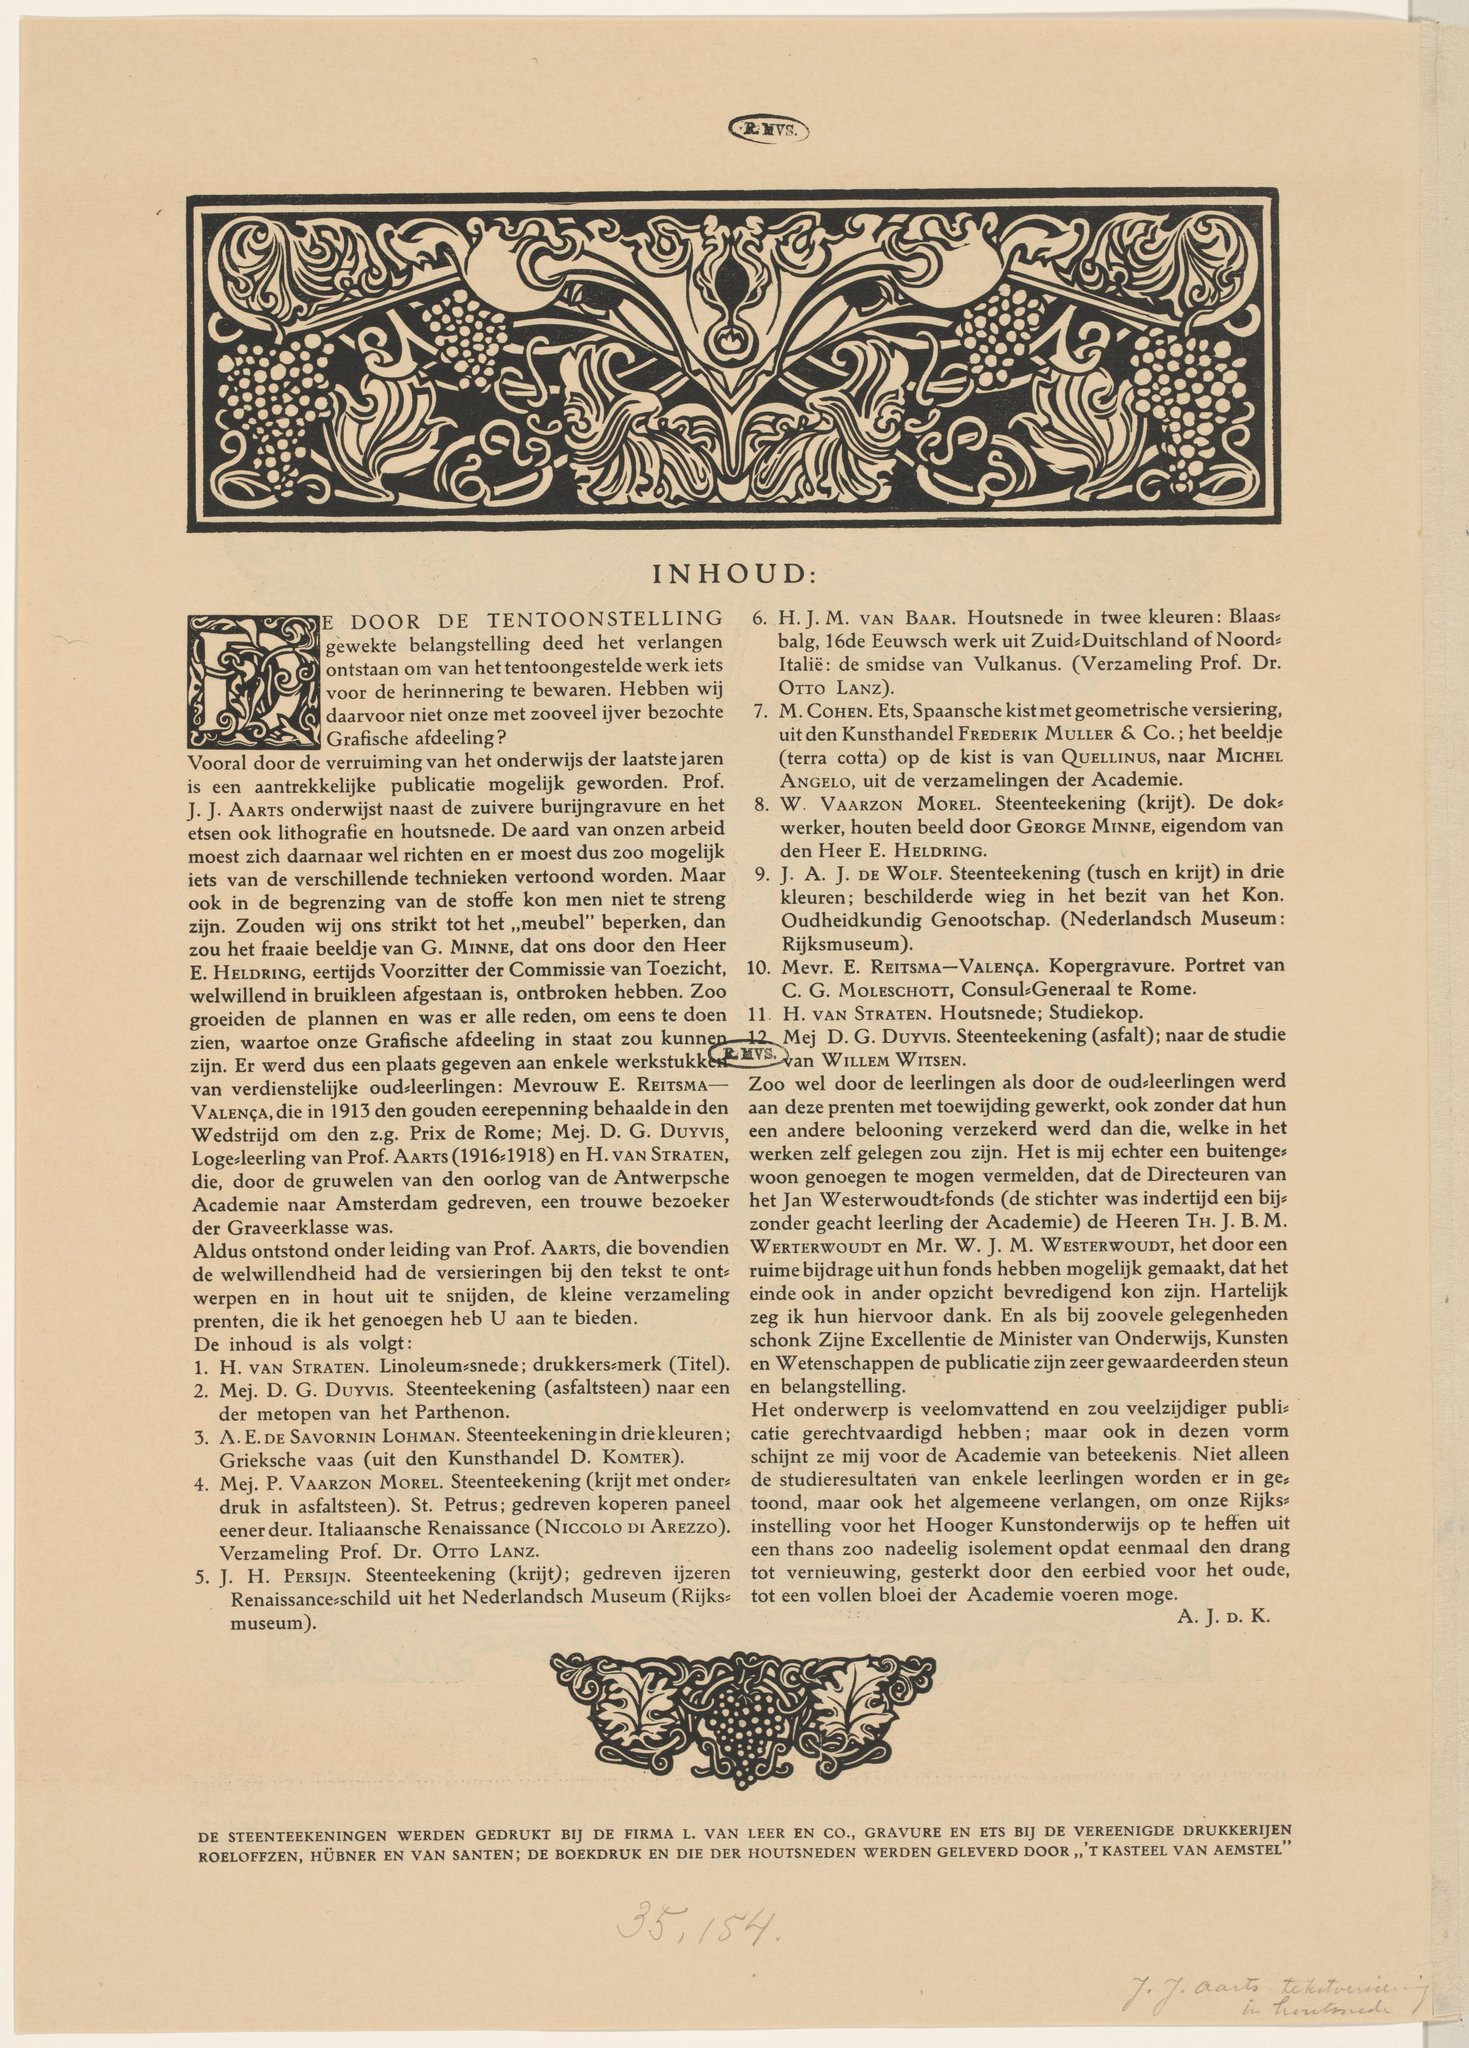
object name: print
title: Drie vignetten met plantmotieven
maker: johannes josephus aarts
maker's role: draughtsman, print maker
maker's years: 1871-1934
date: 1924-1925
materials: paper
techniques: letterpress printing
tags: vignette, bunch of grapes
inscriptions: collector's mark: Lugt 2228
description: Deze vignetten werden gepubliceerd als illustratie bij een tekst van Antoon der Kinderen die een uitgave van prenten van (oud-)leerlingen van de Rijksakademie van Beeldende Kunsten in Amsterdam begeleidde. De verzameling prenten werd in 1925 uitgebracht naar aanleiding van de tentoonstelling 'Het Meubel en de Beeldende Kunsten' in 1924.